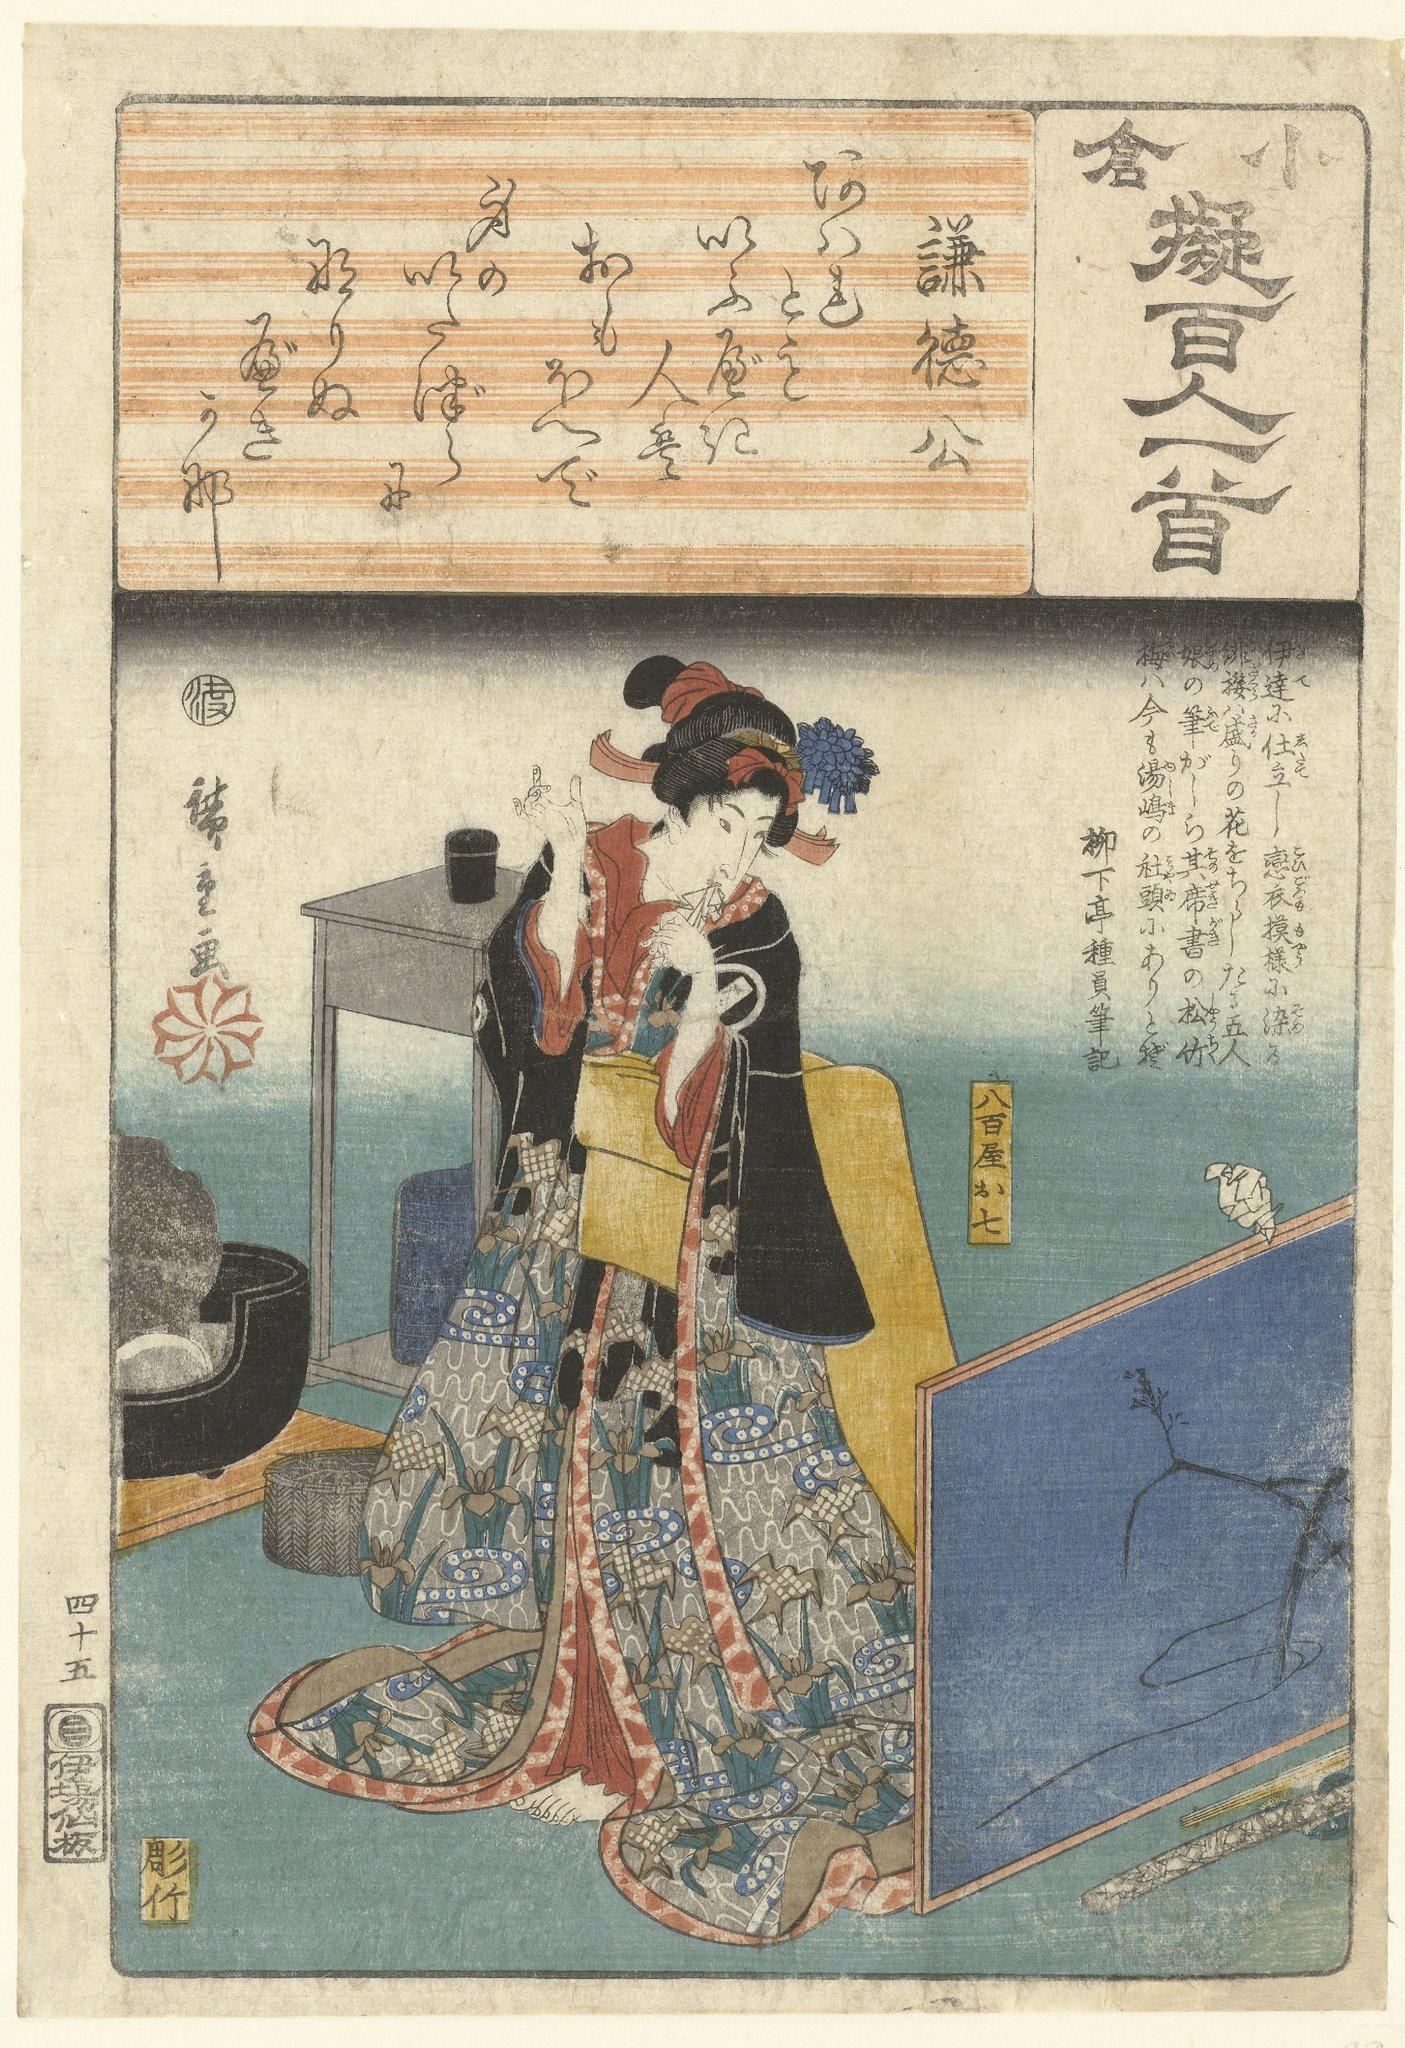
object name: print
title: Yaoya Oshichi kijkend naar haar slapende geliefde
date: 1846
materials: paper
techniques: woodcut, nishiki e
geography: japan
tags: adult woman, interior of the house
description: Courtisane Yaoya Oshichi een papieren prop gooiend over blauw kamerscherm, waarachter haar geliefde Kichisaburo slaapt. Gedicht in oranje gestreept cartouche linksboven; boven kamerscherm een commentaar op de voorstelling.